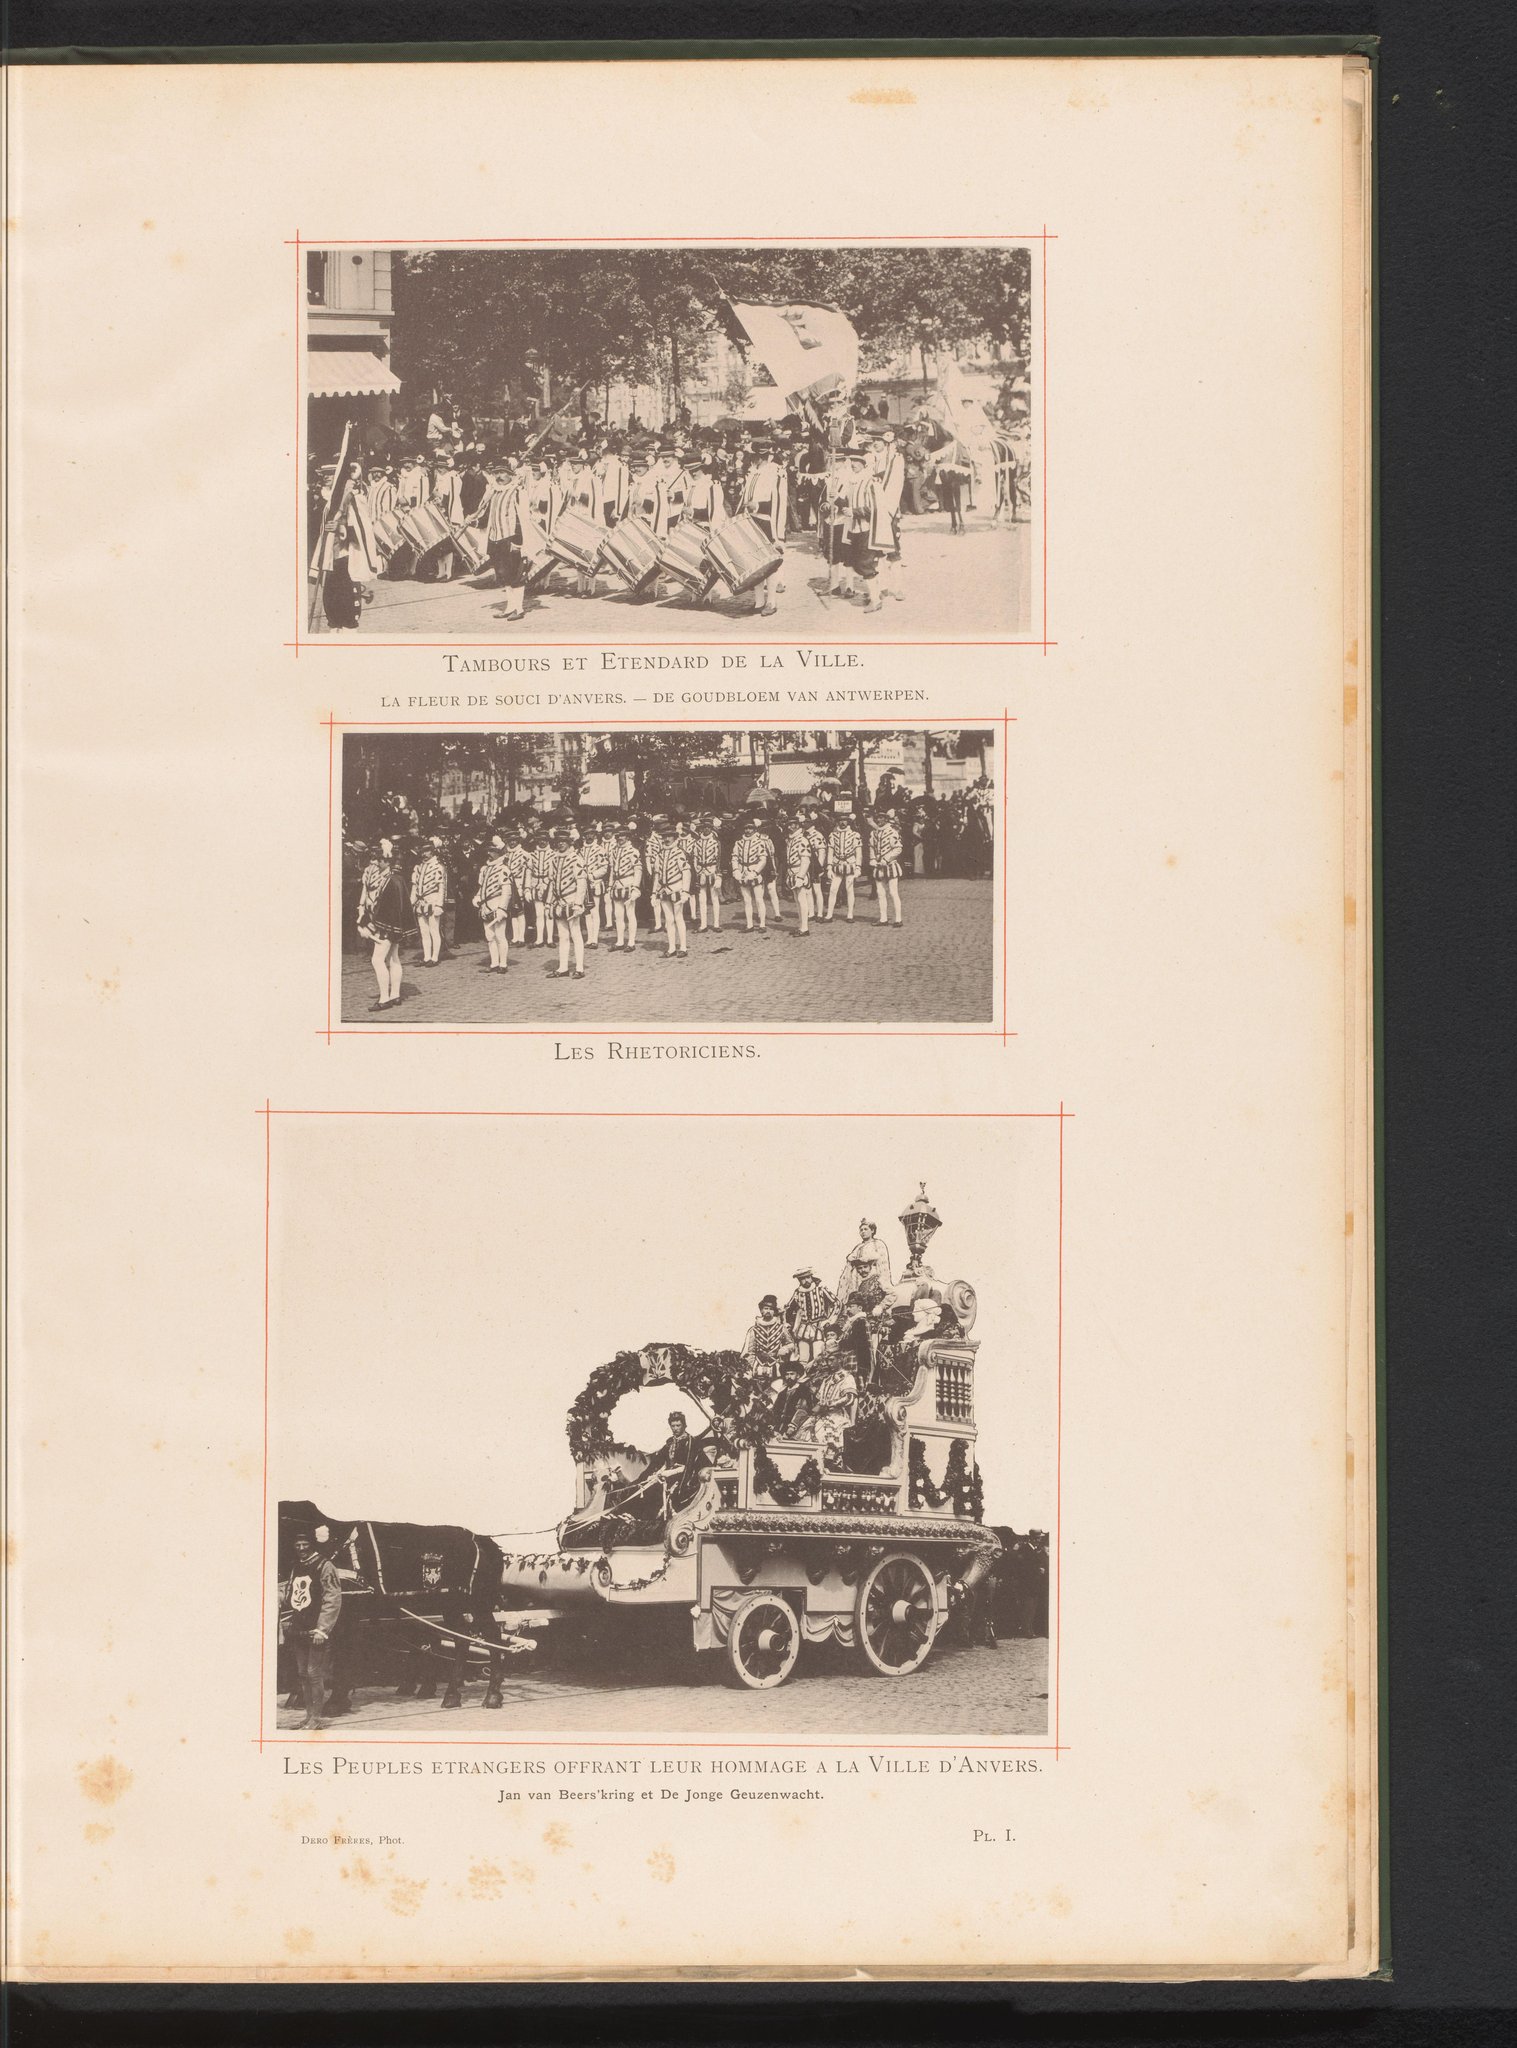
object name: page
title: Tambours et Etendard de la Ville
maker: joseph maes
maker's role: fotograaf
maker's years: 1838-1908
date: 1892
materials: paper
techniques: photograph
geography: antwerp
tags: public festivities (+ parade, pageant, cavalcade ~ festive activities), antwerp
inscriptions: inscription: ‘LA FLEUR DE SOUCI D'ANVERS. - DE GOUDBLOEM VAN ANTWERPEN.’, inscription: ‘Jan van Beers'kring et De Jonge Geuzenwacht.’, number: ‘Pl. 1.’